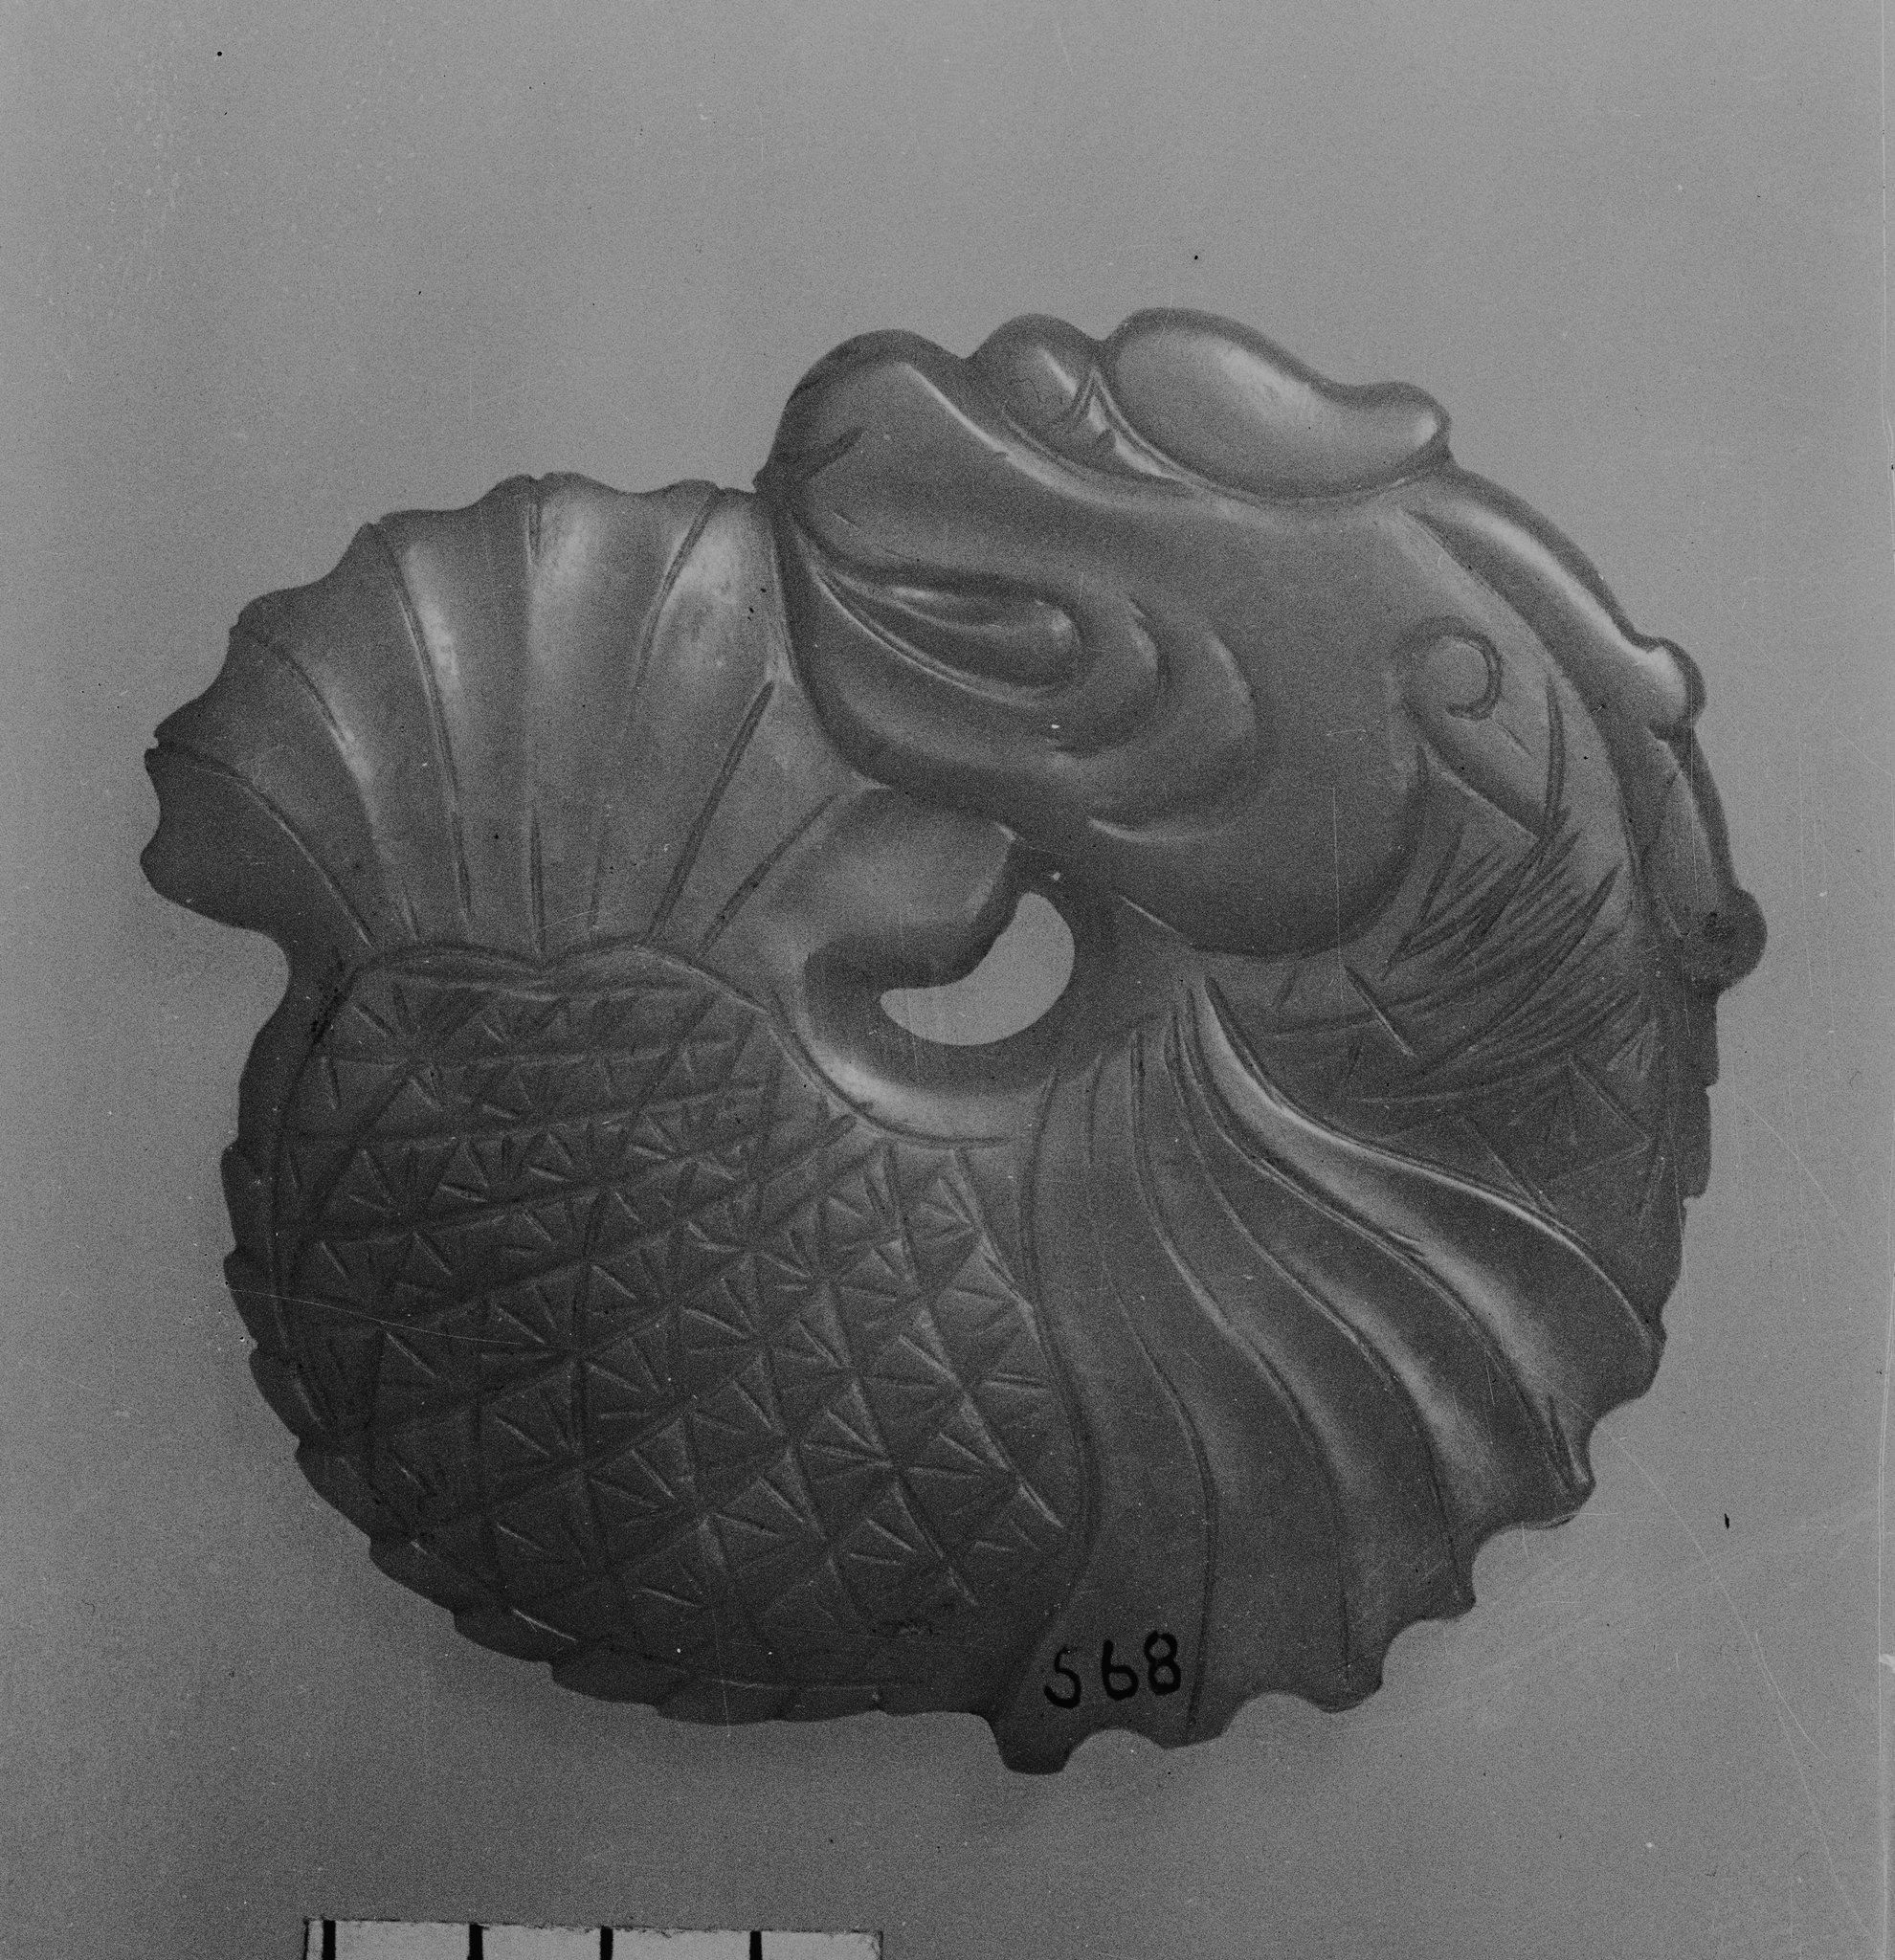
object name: paperweight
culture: chinese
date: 1736-1795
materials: jade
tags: mythical creatures